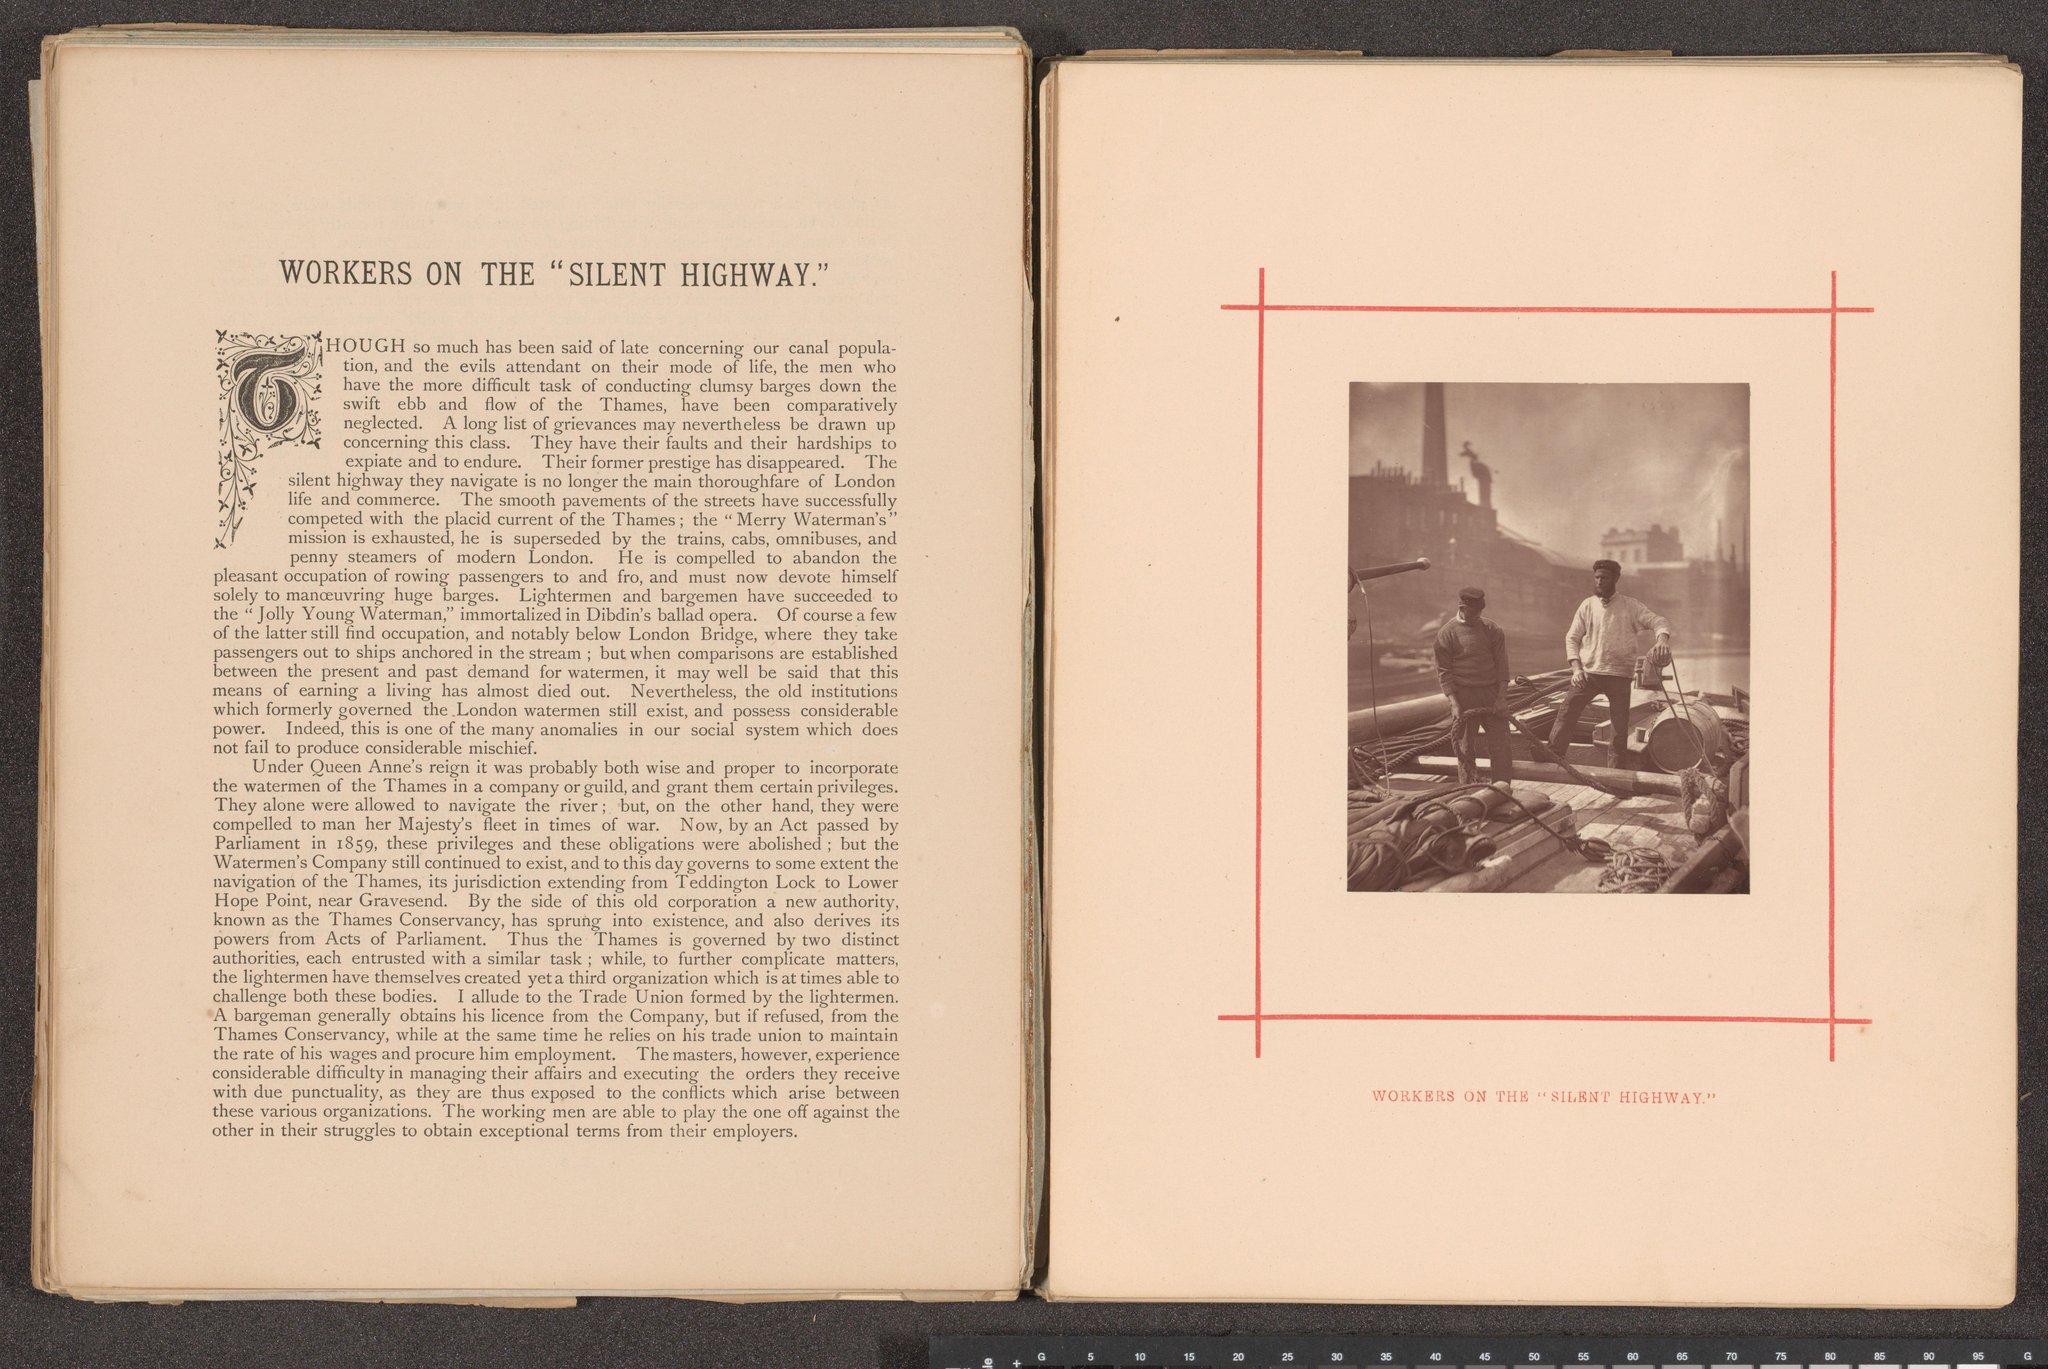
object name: photomechanical print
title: Workers on the Silent Highway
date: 1876-1877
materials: paper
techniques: woodburytype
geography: thames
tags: crew ~ ship, london, thames